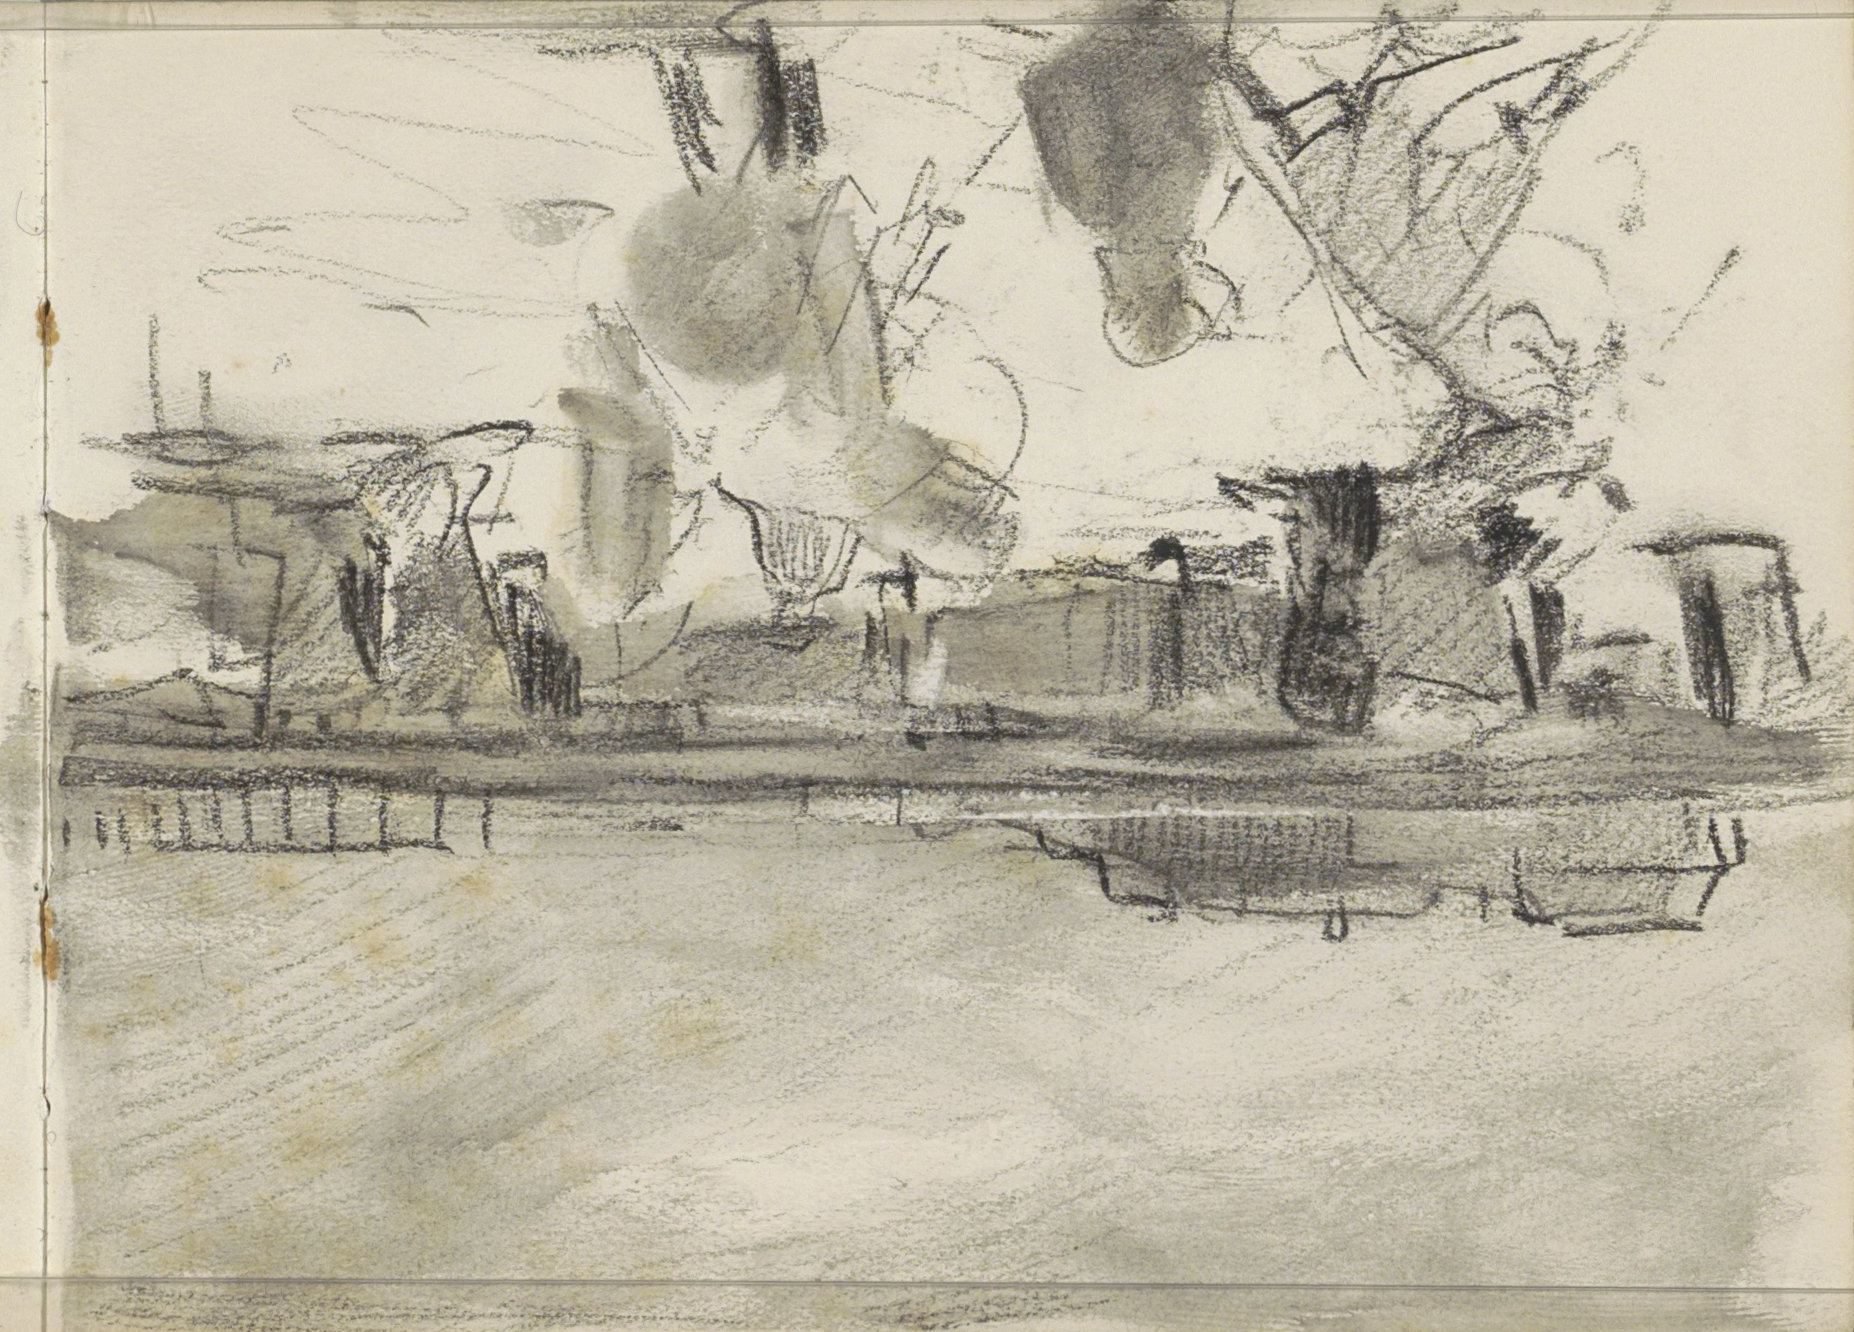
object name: sketchbook leaf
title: Figuren op het strand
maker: johan antonie de jonge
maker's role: draughtsman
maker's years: 1864-1927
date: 1920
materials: chalk, paper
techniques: stumping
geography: south holland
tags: beach (as place of recreation), beach (+ landscape with figures, staffage)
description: Figuren op het strand. Op de achtergrond gebouwen. Blad 11 recto uit een schetsboek met 21 bladen.